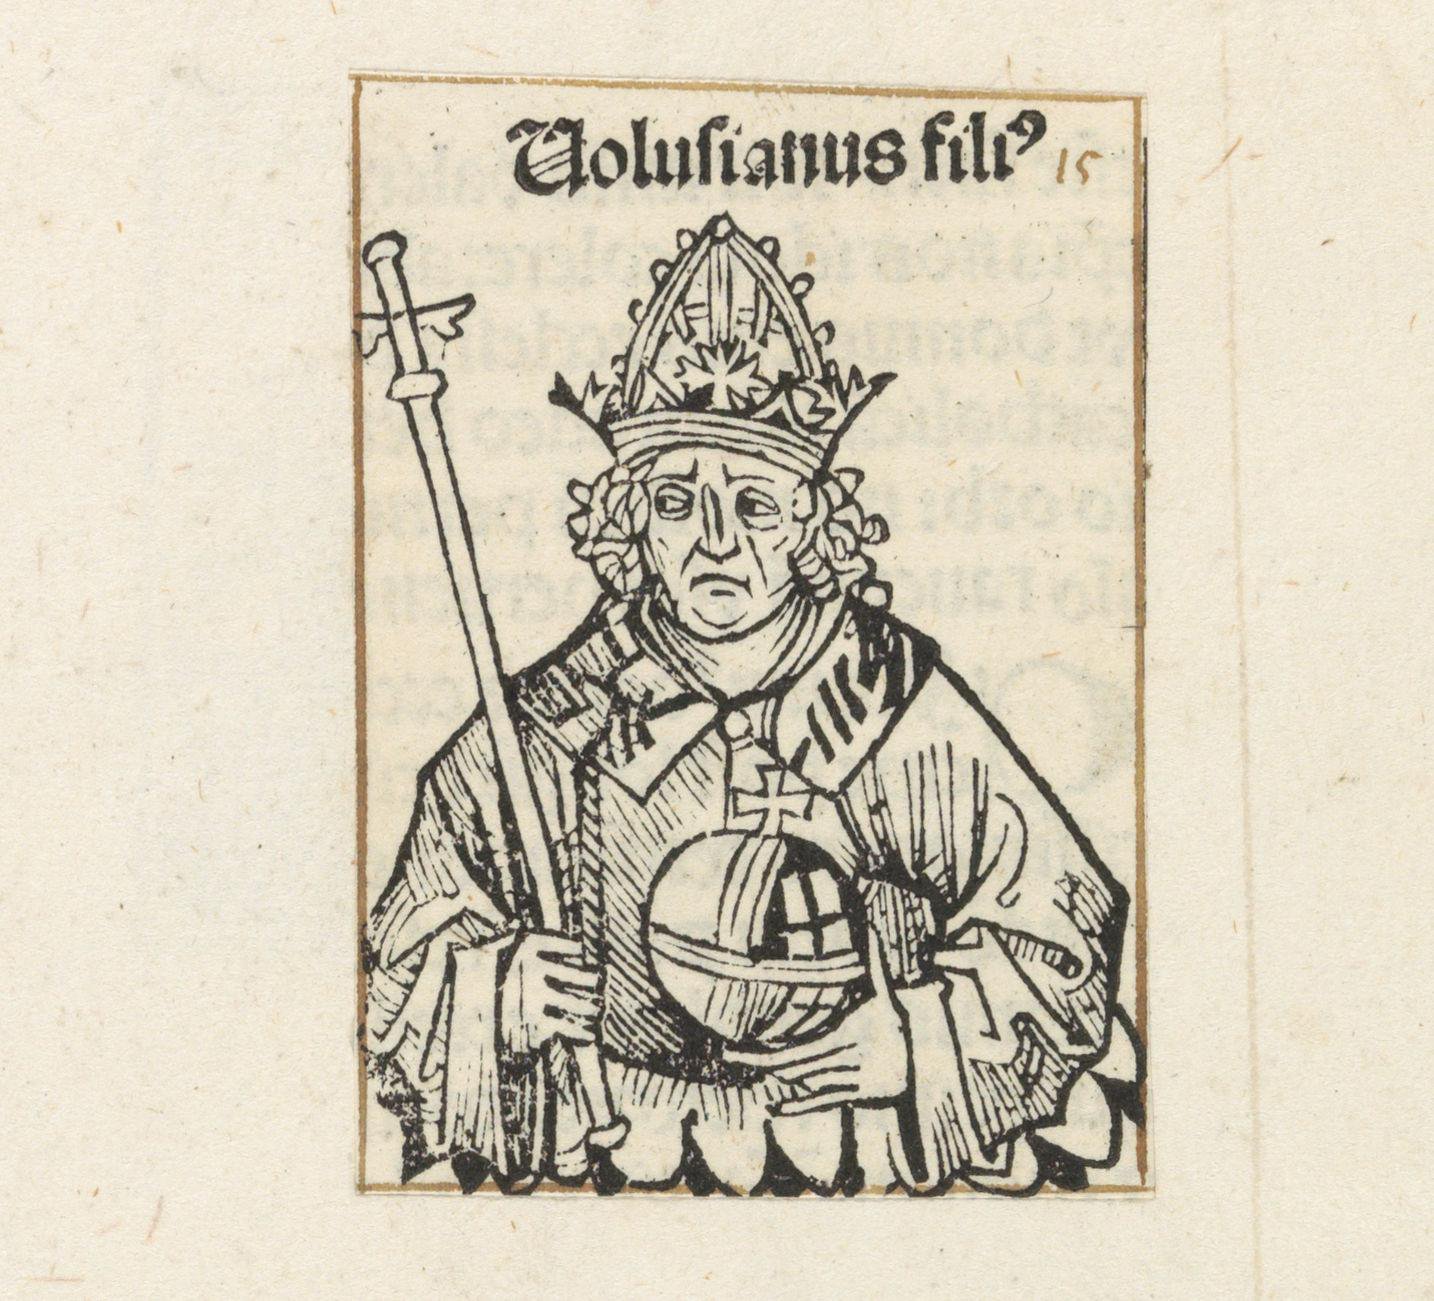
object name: print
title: Keizer Volusianus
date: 1493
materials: paper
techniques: letterpress printing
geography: nuremberg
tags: emperor, king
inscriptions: inscription: ‘15’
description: Een bloemkelk met een koning, naar voren gericht. Hij heeft een scepter en rijksappel in zijn handen. De voorstelling is onderdeel van de opeenvolging Romeinse keizers in de Liber Chronicarum. De tekst identificeert de man als keizer Volusianus. De prent maakt deel uit van een album.